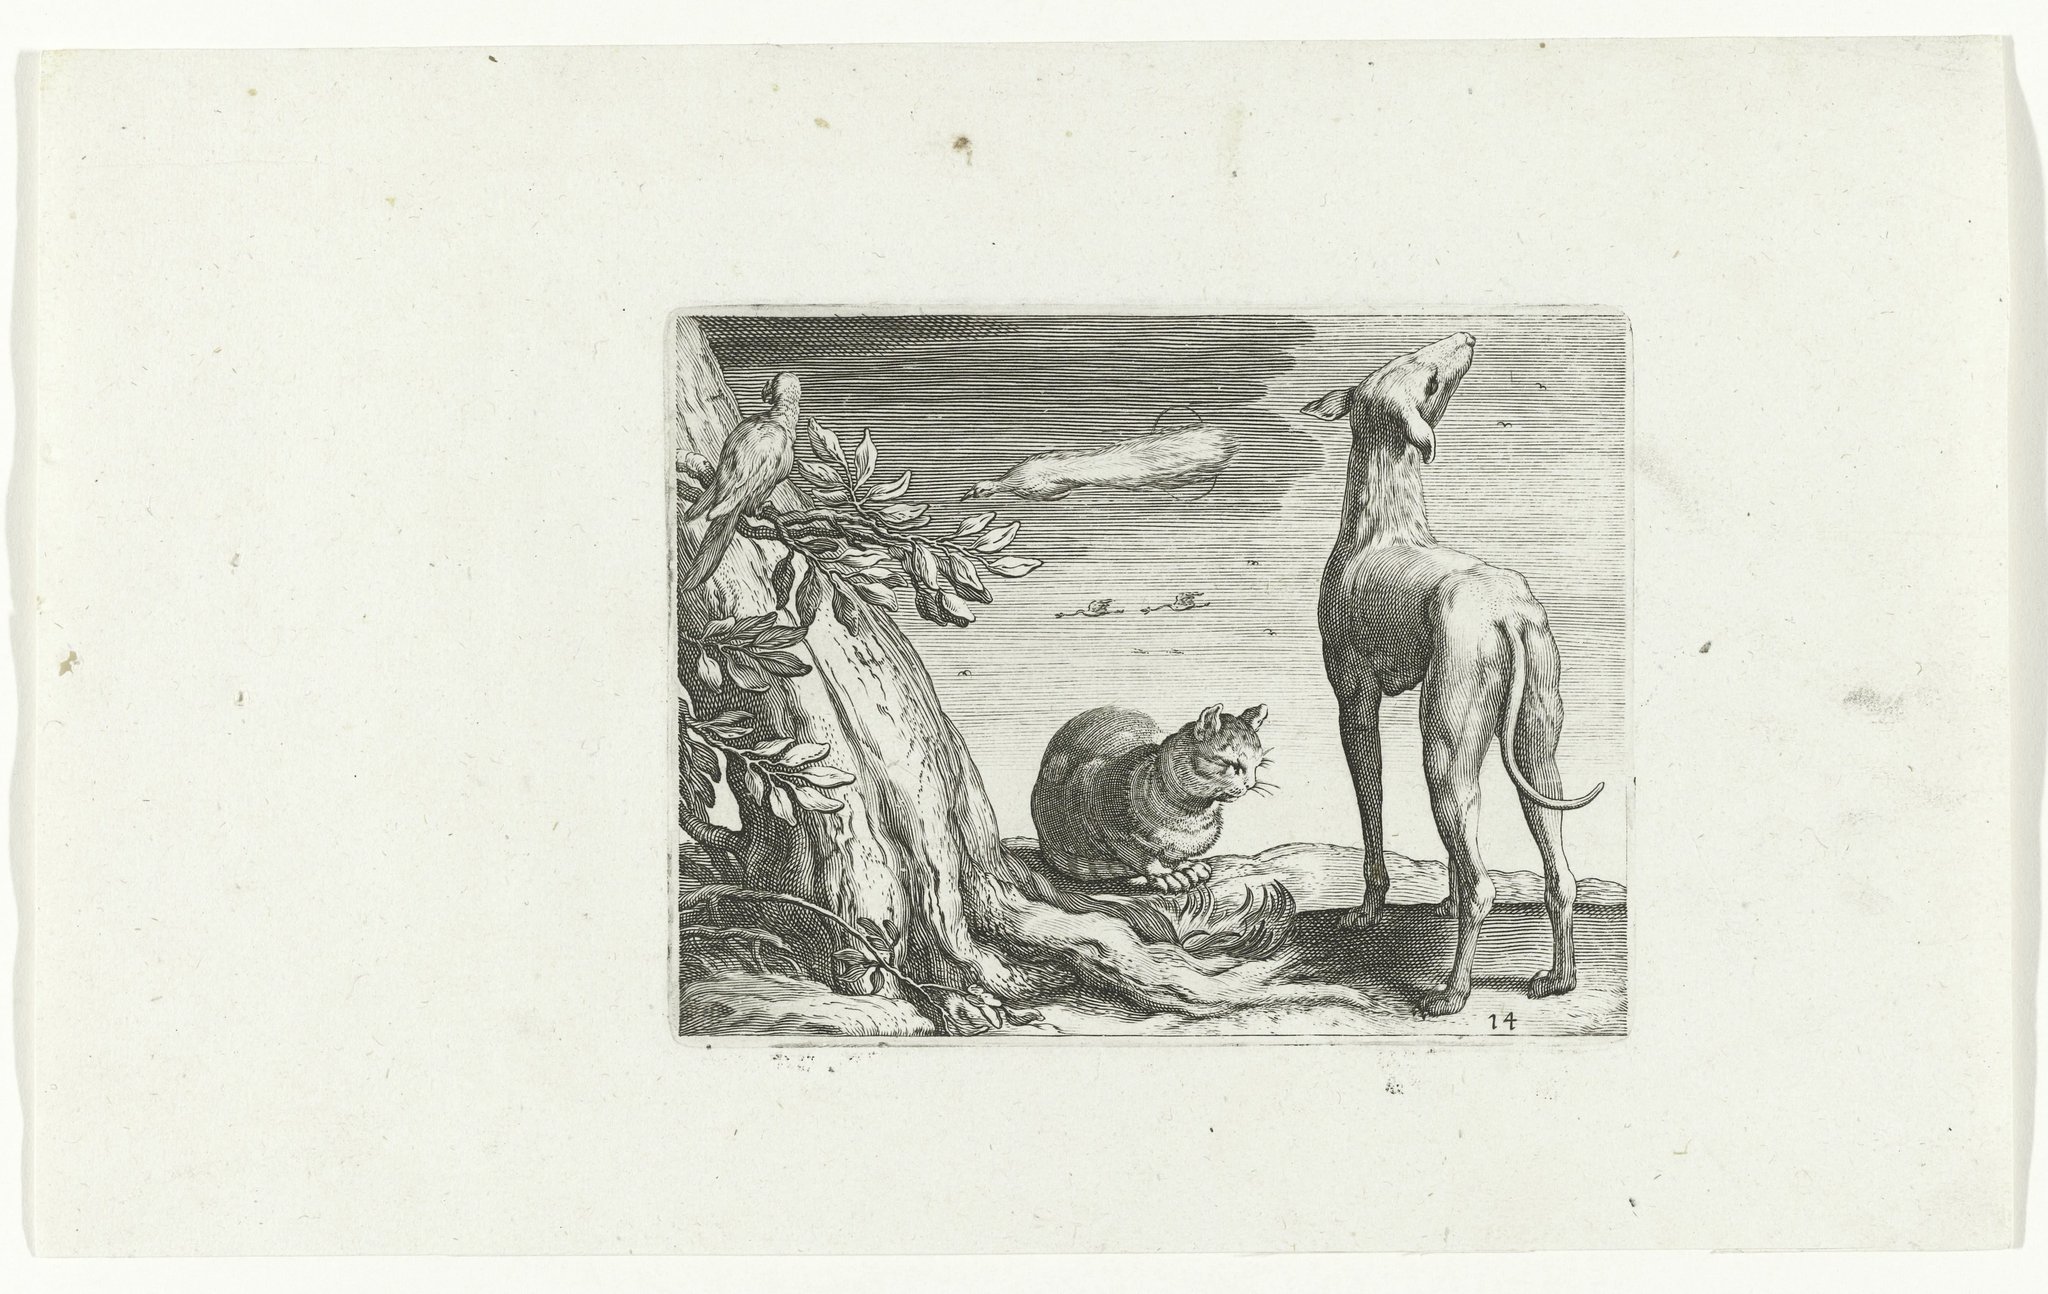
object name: print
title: Vogel op tak, vogel in de lucht, kat en hond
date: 1604-1650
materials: paper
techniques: engraving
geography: netherlands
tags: cat, birds, dog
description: De hond, vogel in de lucht en vogel op tak zijn gekopieerd naar een prent van Saenredam naar ontwerp van Bloemaert (Hollstein 1). De kat is gekopieerd naar een andere prent van Saenredam naar ontwerp van Bloemaert (Hollstein 3).